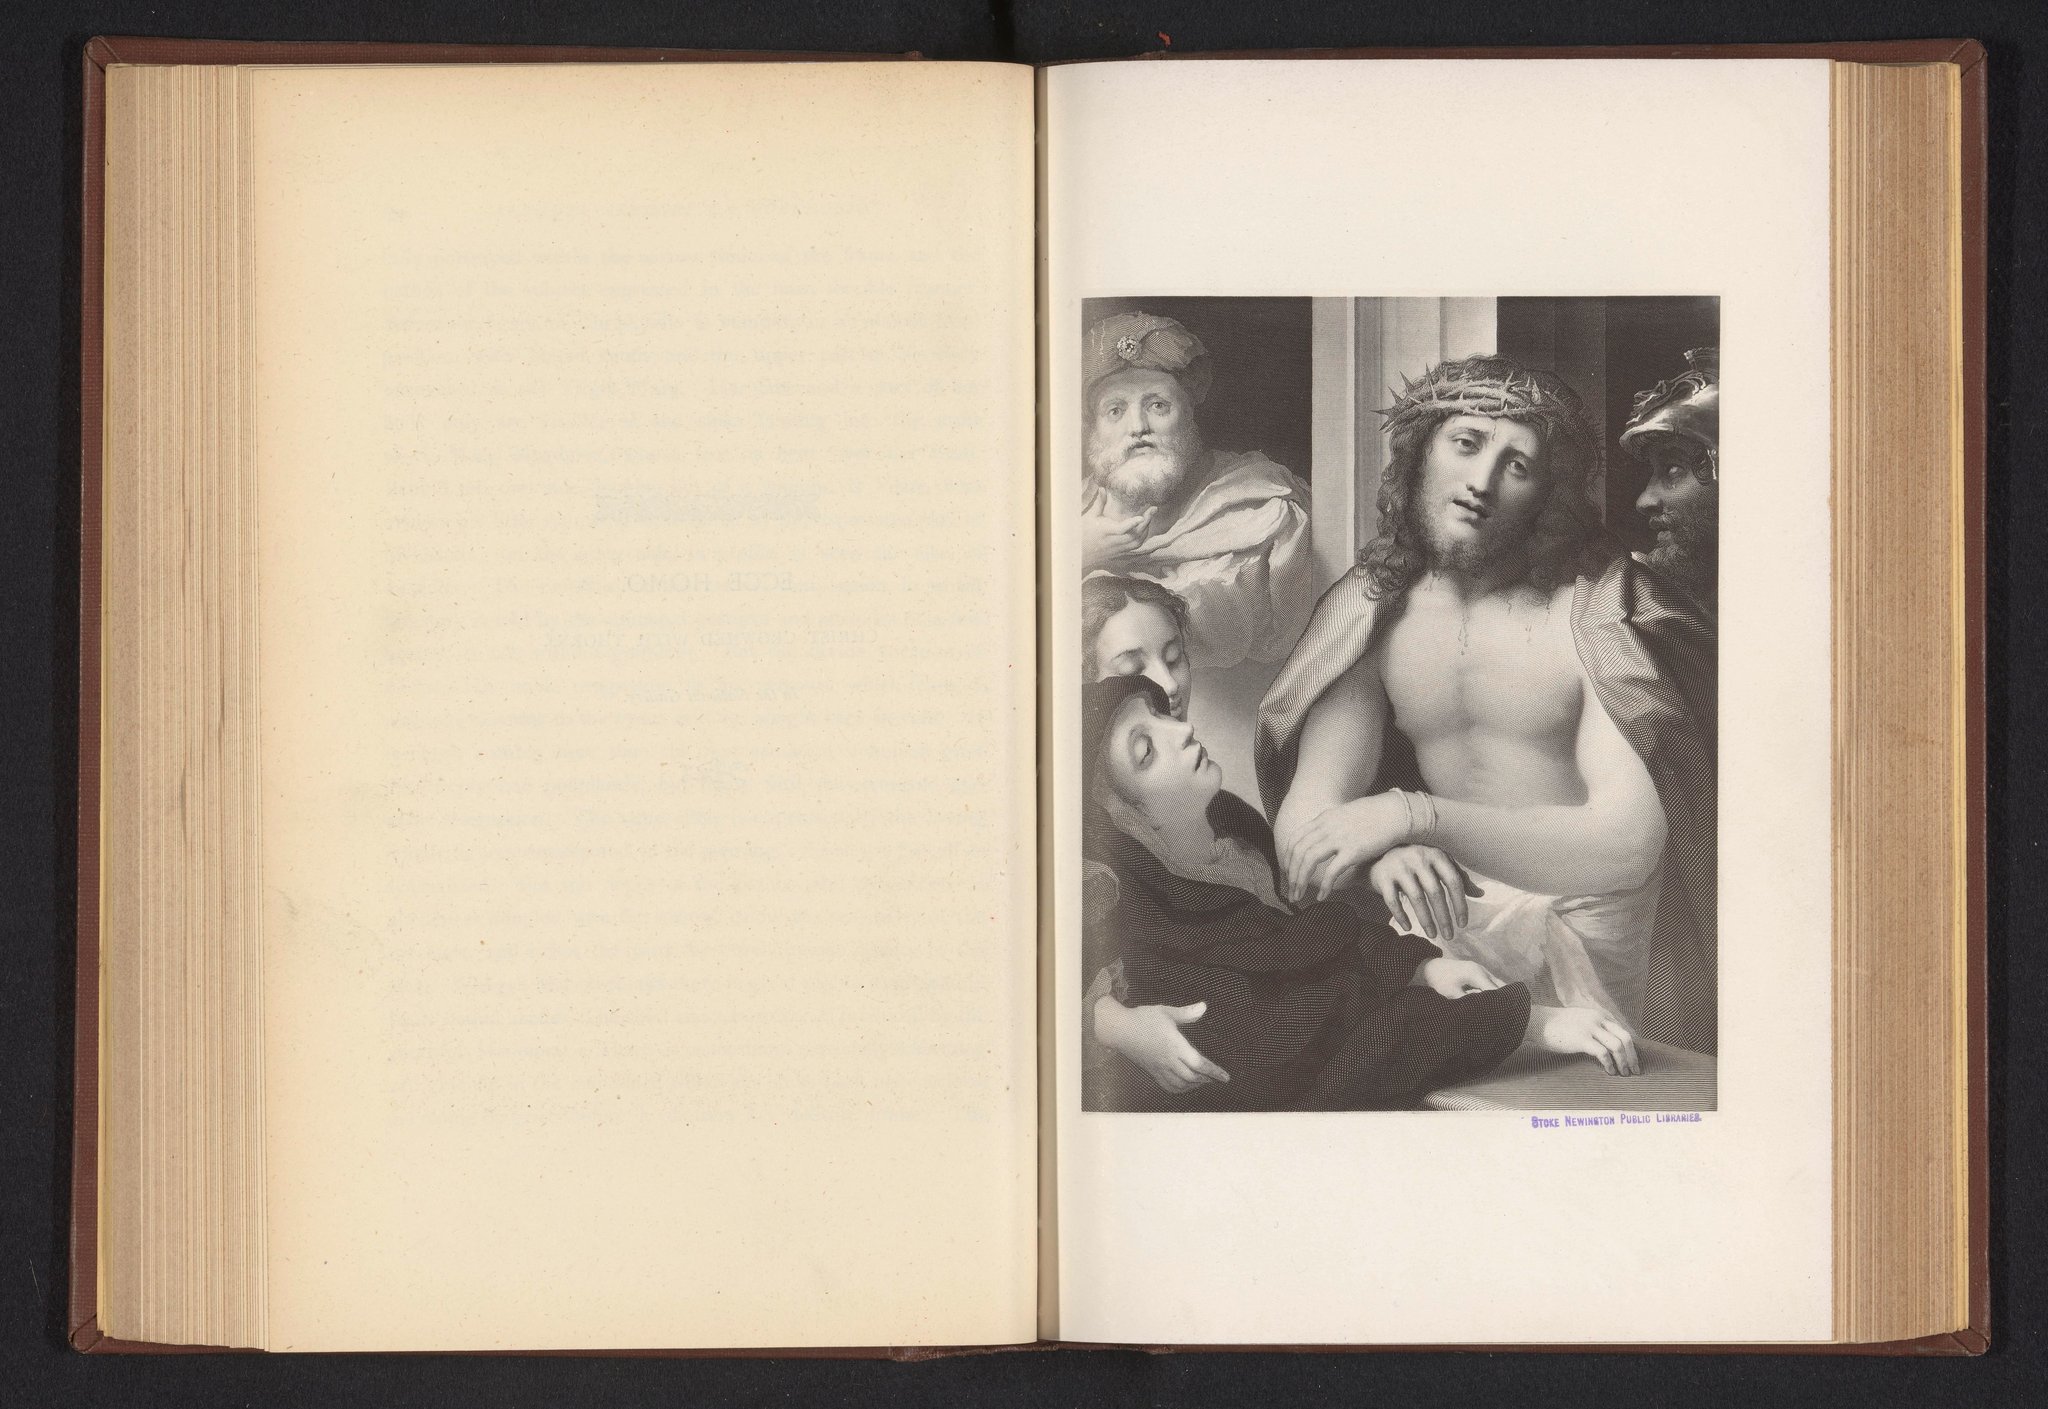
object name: photomechanical print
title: Fotoreproductie van een prent naar een schilderij, voorstellende Christus voor Pilatus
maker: Anonymous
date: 1870-1876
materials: paper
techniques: photograph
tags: pilate showing christ to the people, 'ostentatio christi', 'ecce homo' (john 19:4-6)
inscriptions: inscription: ‘Stoke Newington Public Libraries’